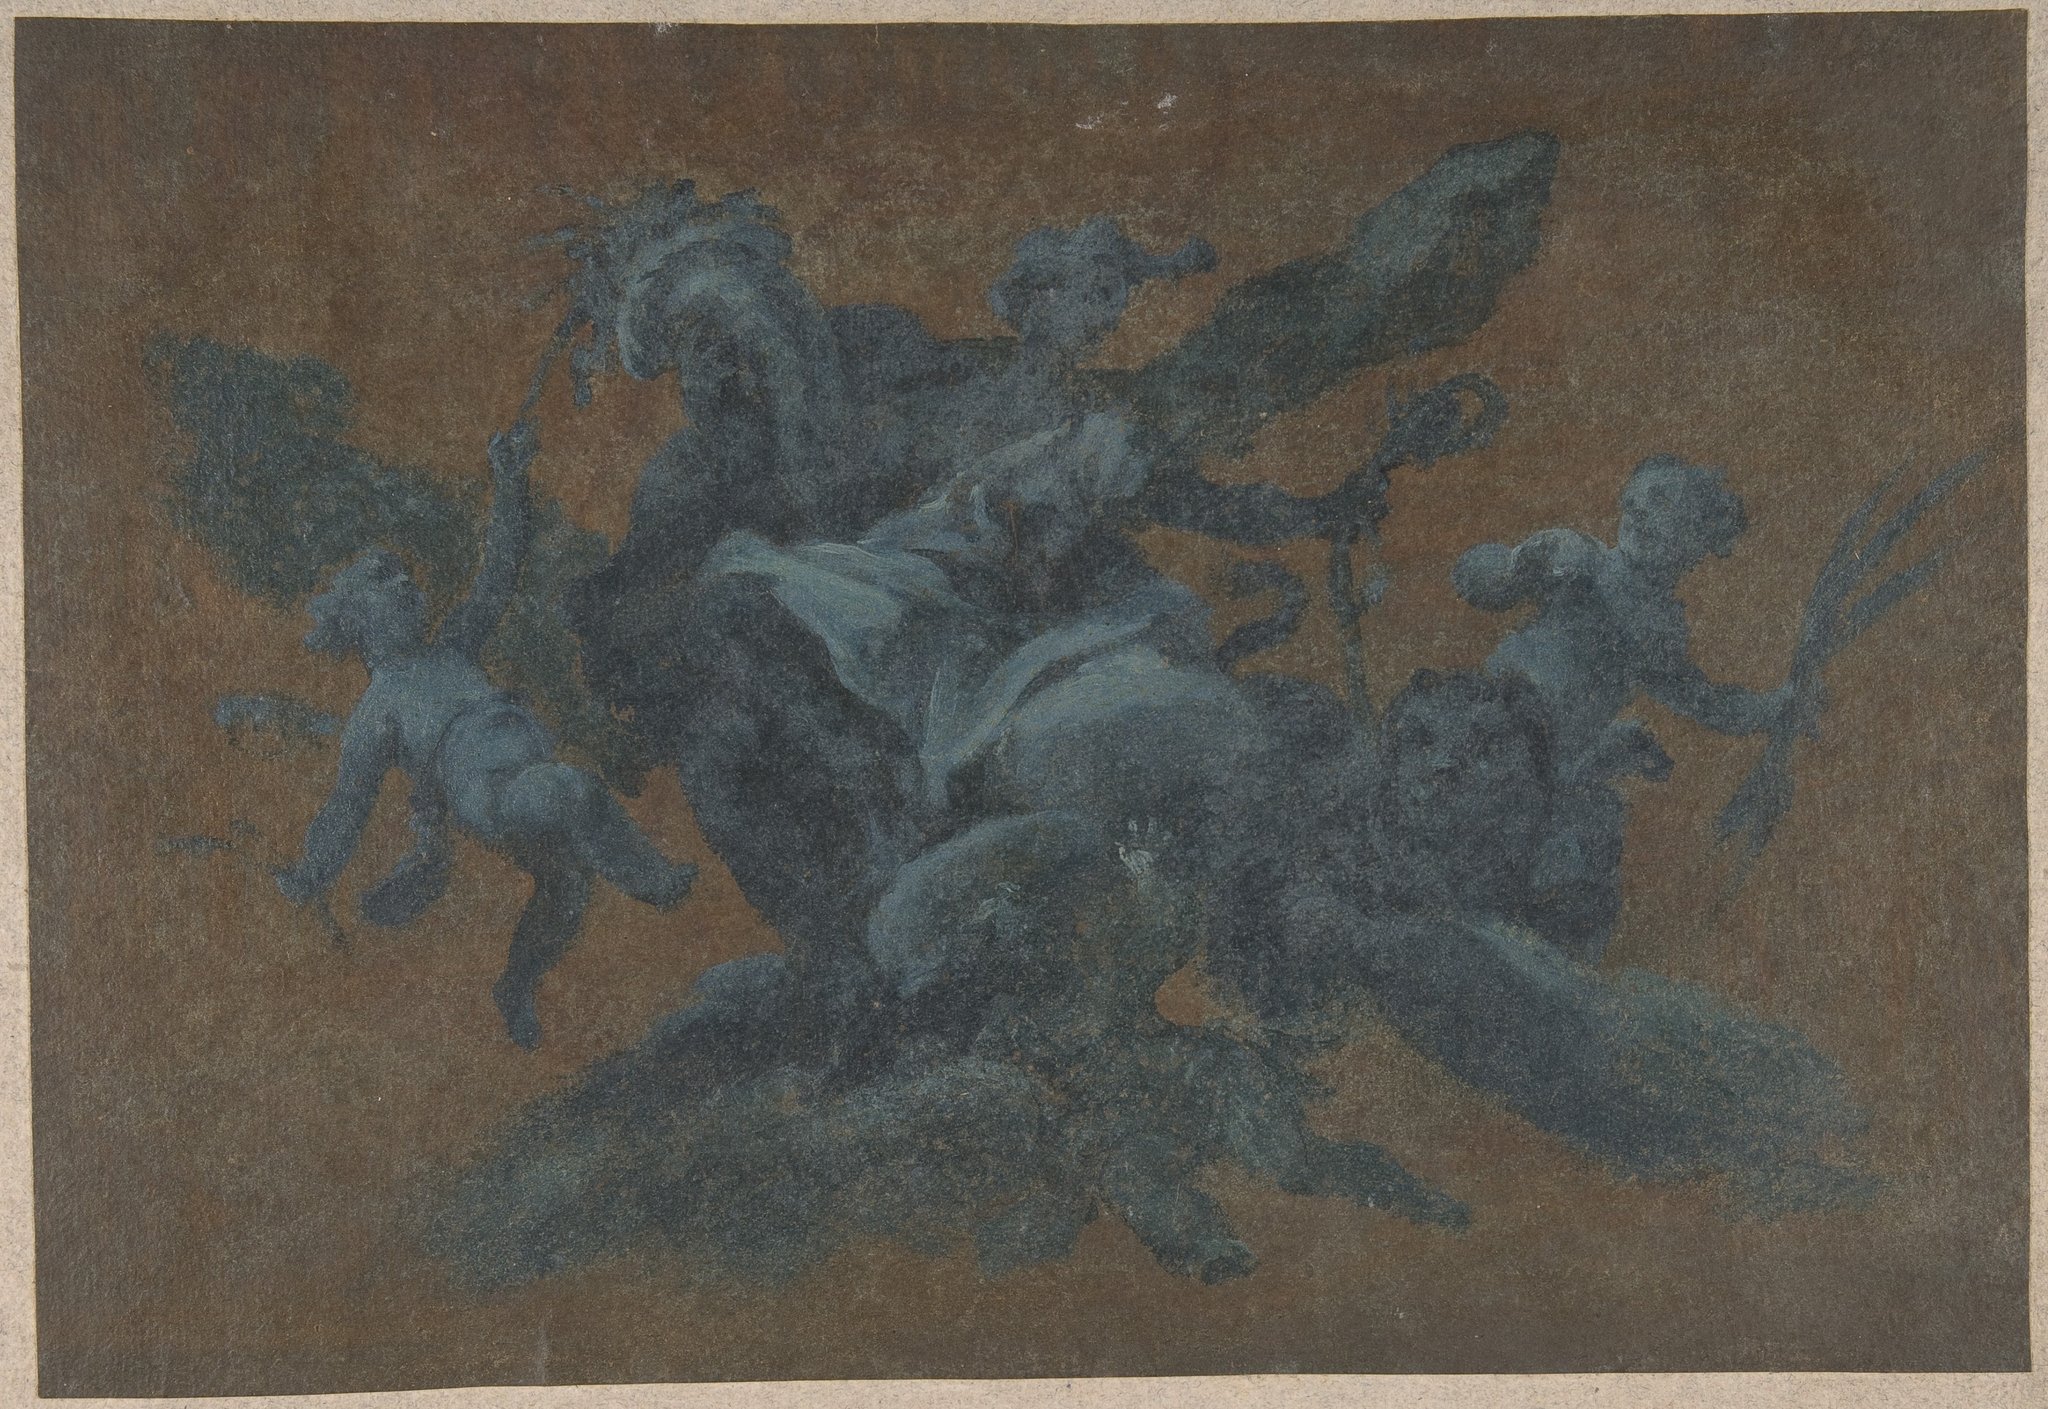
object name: drawing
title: Allegorical Figure of Abundance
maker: anonymous, italian, 18th century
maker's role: artist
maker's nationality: italian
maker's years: 1700-1800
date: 1701-1800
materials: oil, paper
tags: human figures